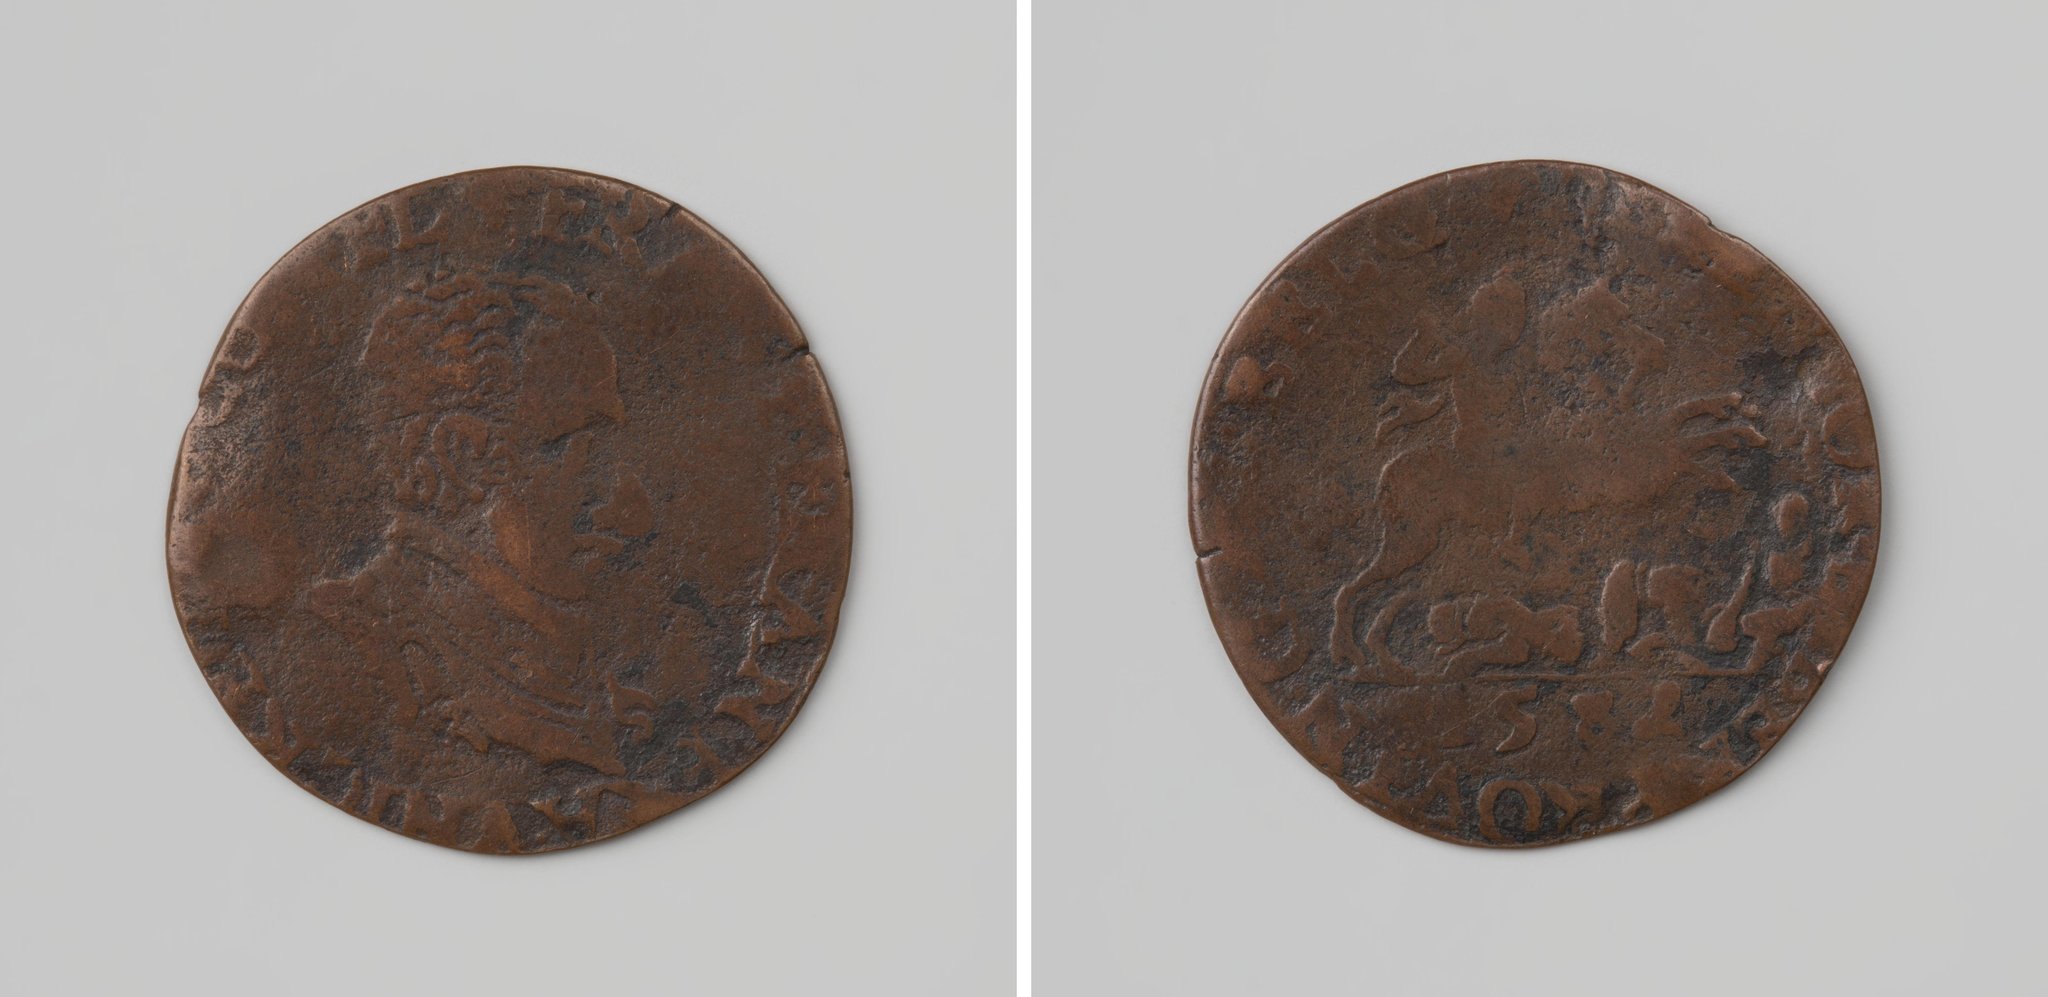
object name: jeton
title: Overwinningen op de Spanjaarden in Vlaanderen, rekenpenning ter ere van Francois-Hercule, hertog van Anjou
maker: Anonymous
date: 1582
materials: copper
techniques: striking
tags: paris, françois-hercule de valois (hertog van anjou), ghent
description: Koperen penning. Voorzijde: borststuk man binnen omschrift. Keerzijde: ruiter bestrijdt met lans vijand binnen omschrift; afsnede: jaartal